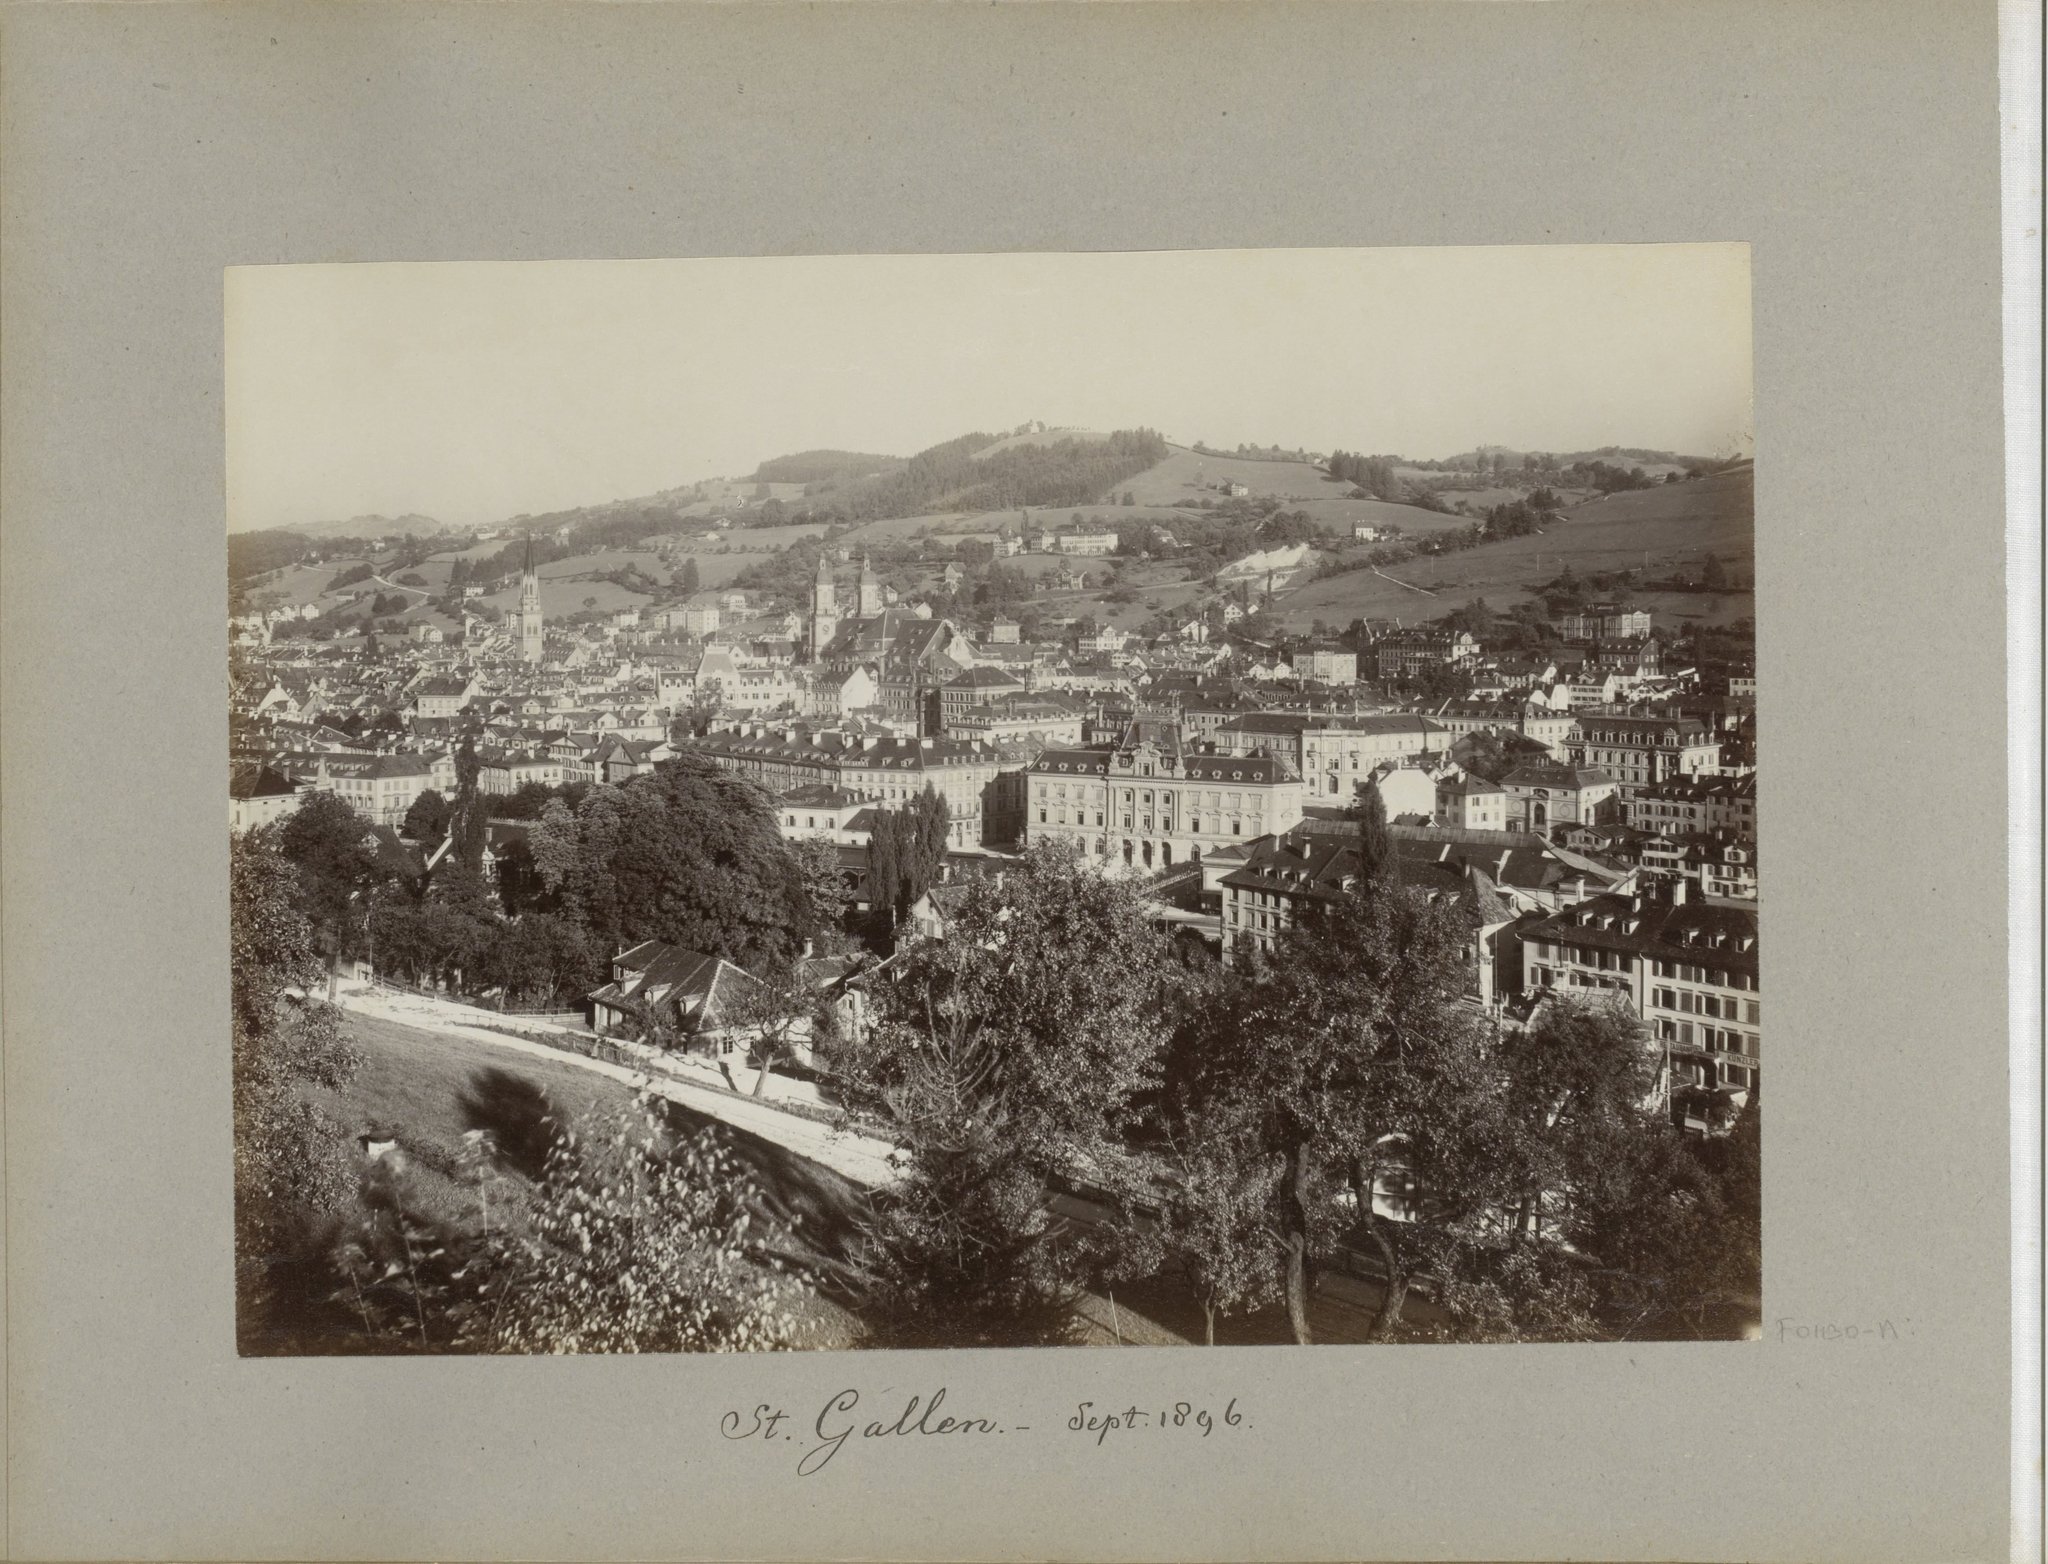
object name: photograph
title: Gezicht op Sankt Gallen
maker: Anonymous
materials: paper, photographic support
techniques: albumen print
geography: sankt gallen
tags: prospect of city, town panorama, silhouette of city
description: Onderdeel van Reisalbum met foto's van bezienswaardigheden in Frankrijk, Spanje, Italië, Duitsland, Zwitserland en Oostenrijk.